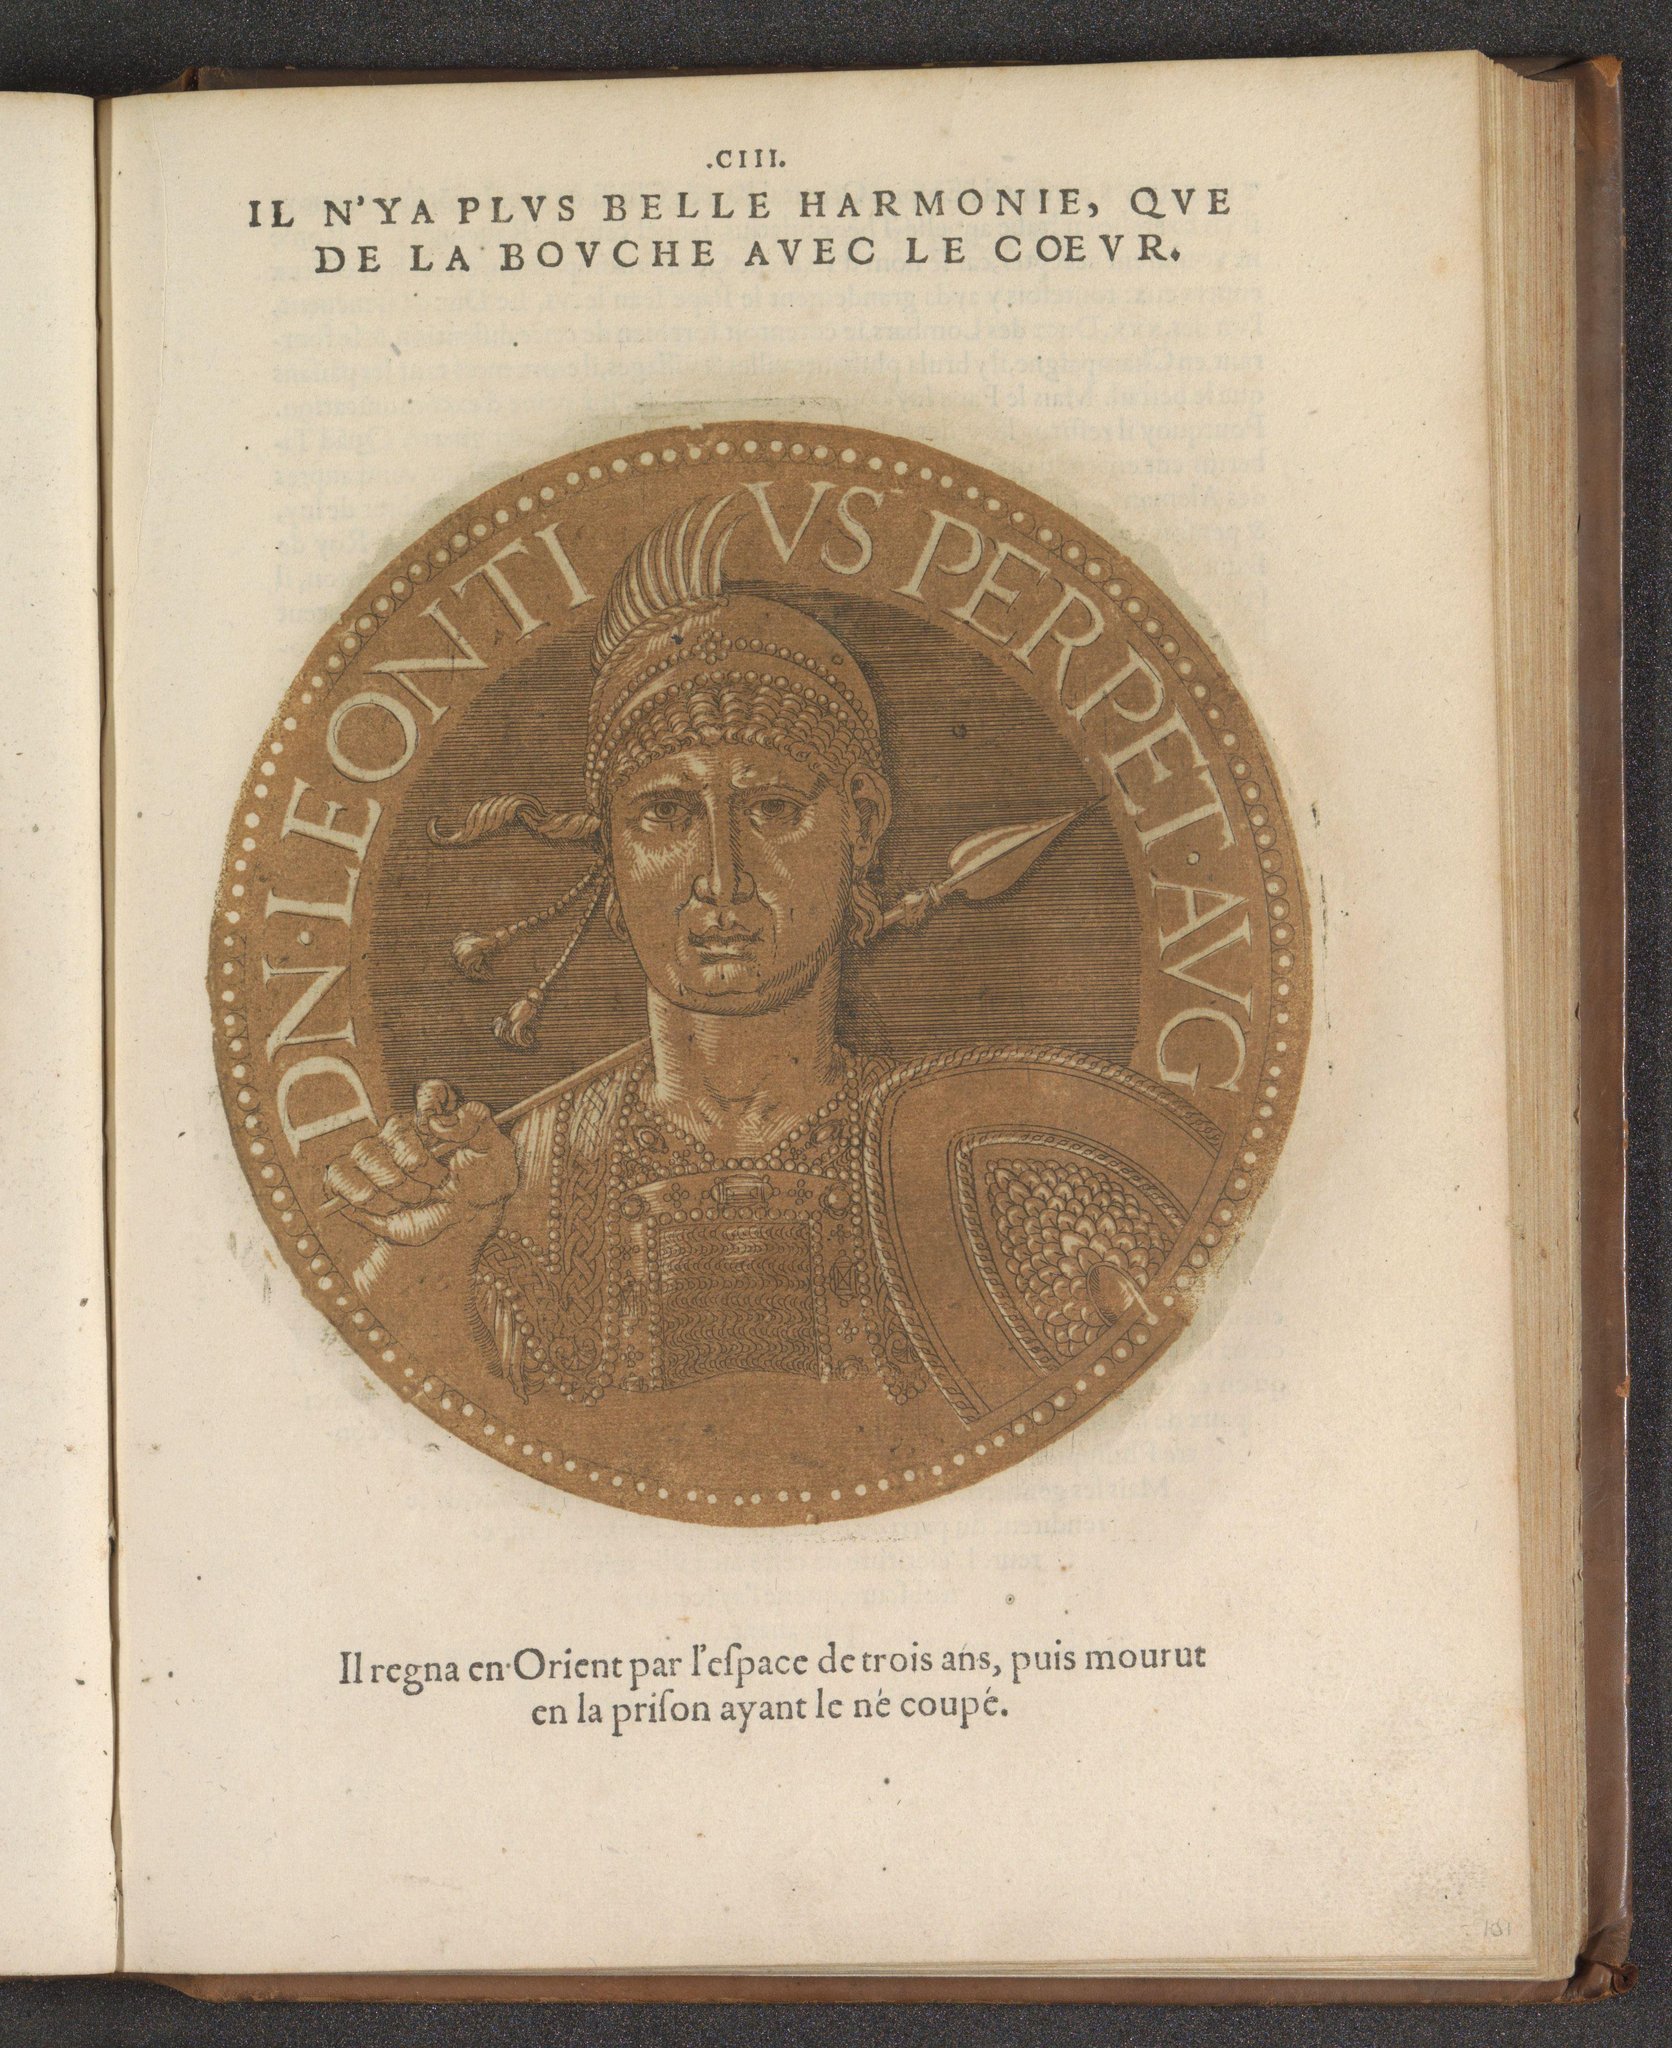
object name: print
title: Les images presque de tous les empereurs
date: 1557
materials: paper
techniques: woodcut, etching, letterpress printing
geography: antwerp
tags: emperor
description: Portretten van keizer Leontios, op een munt met randschrift. De prent maakt deel uit van een boek over de keizers vanaf Julius Caesar tot en met Karel V en zijn broer Ferdinand.